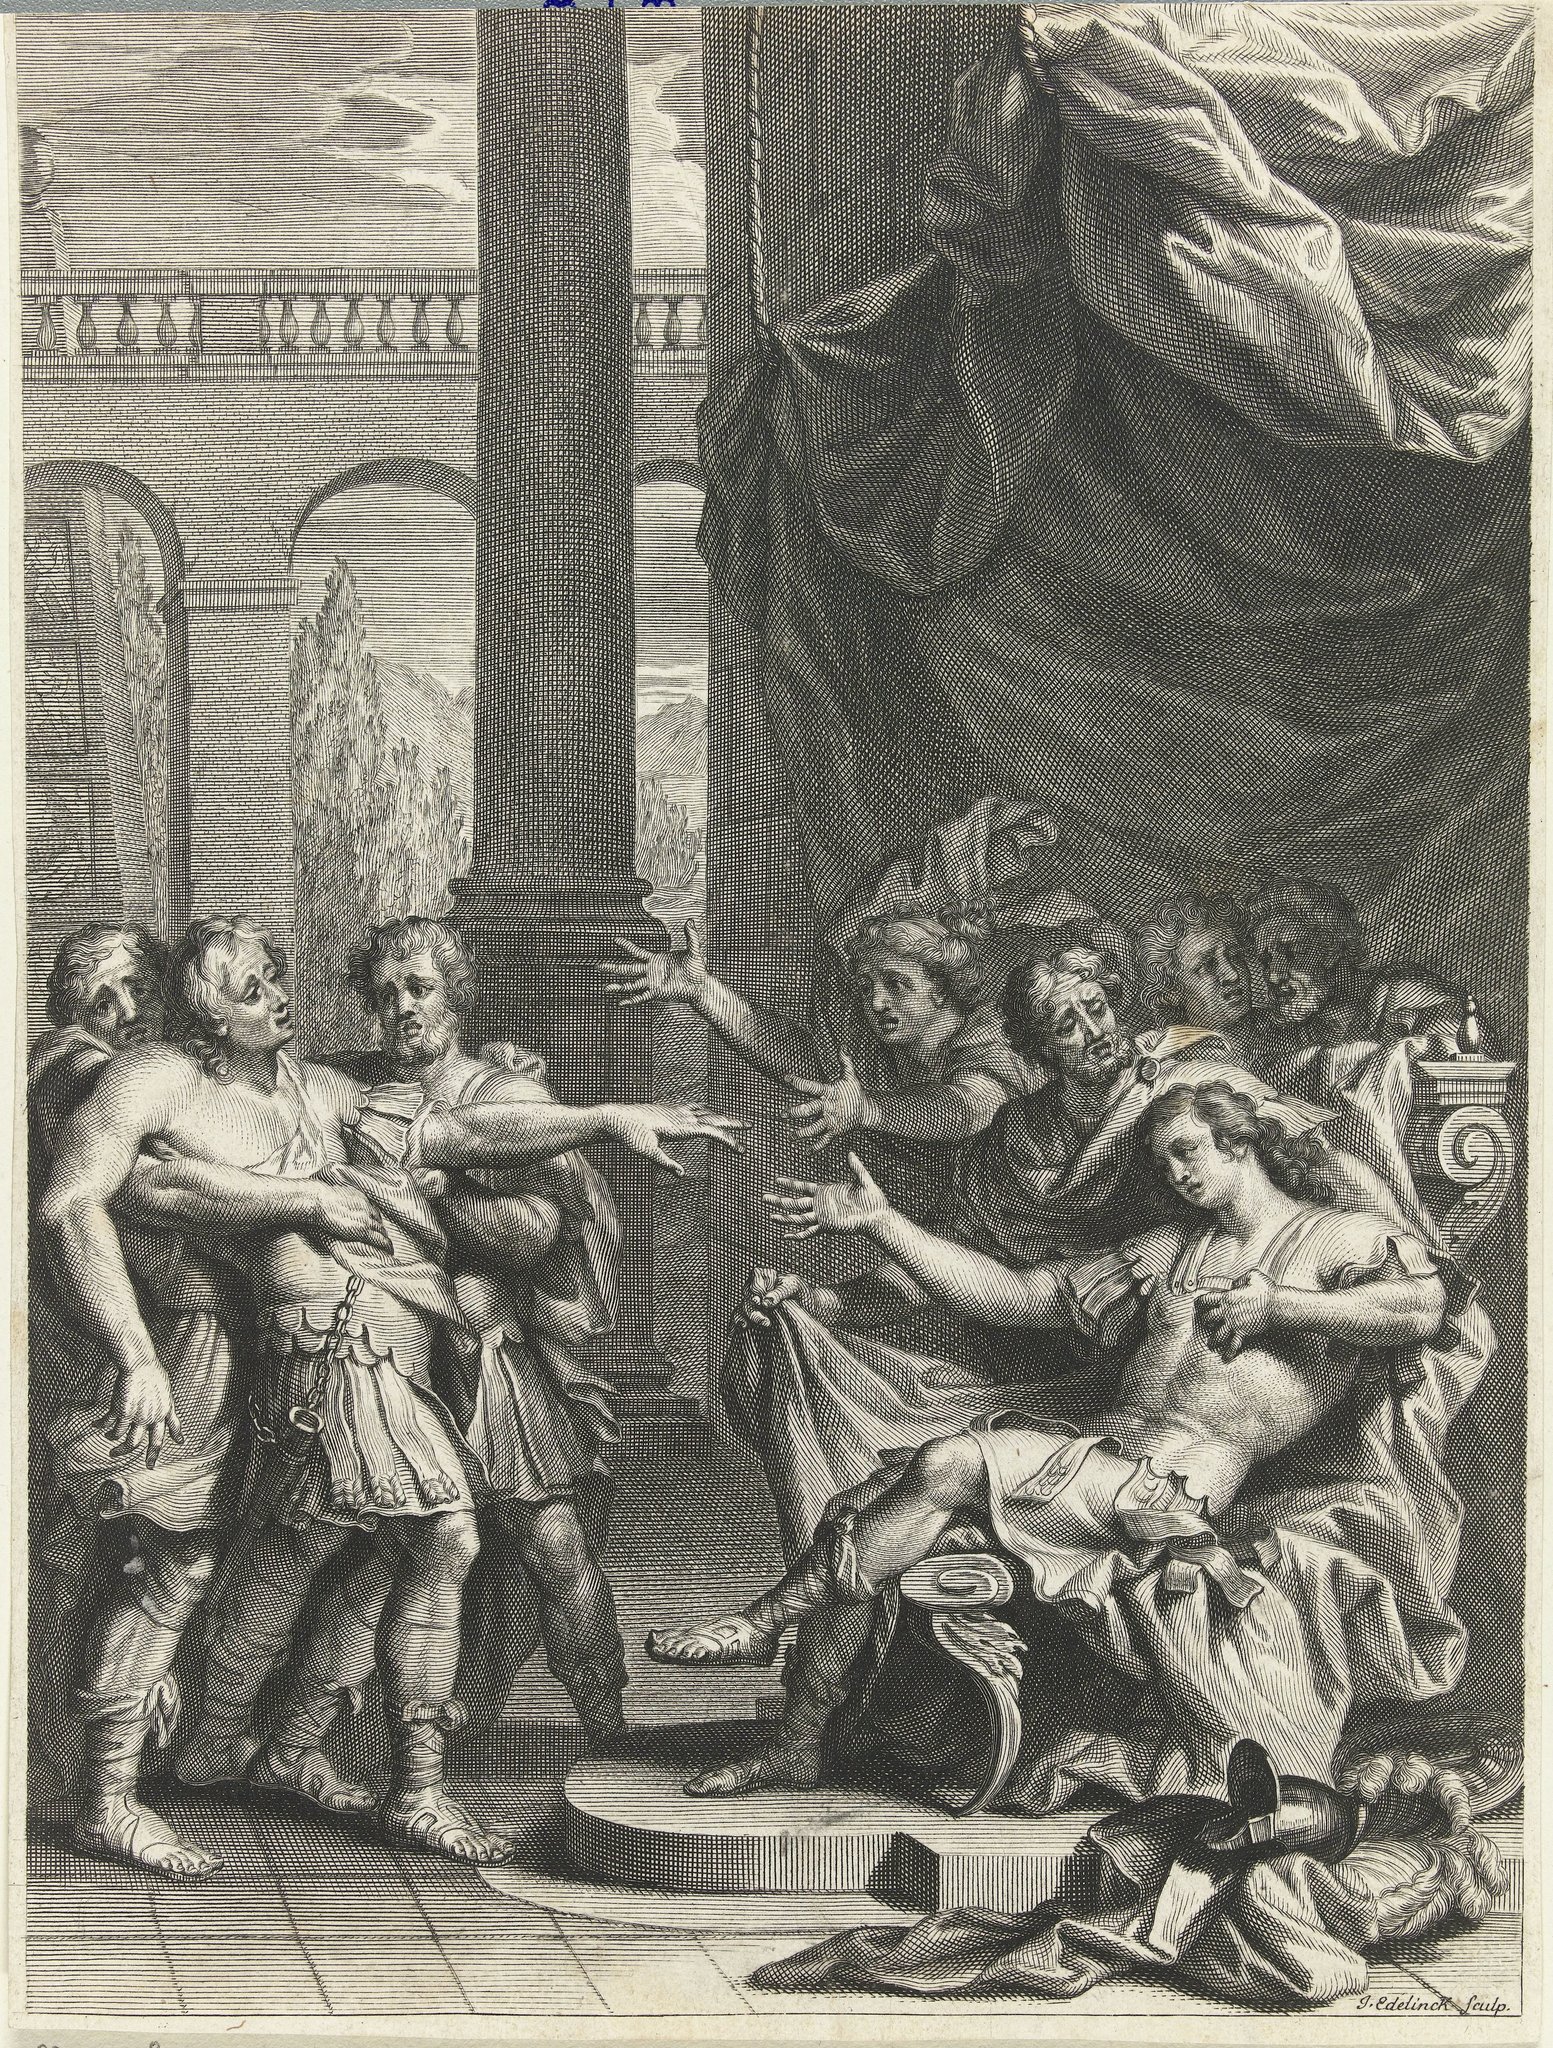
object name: titelblad, titelpagina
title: Titelpagina voor Caroli Ruaei e Societate Jesu Carminum libri quatuor, Parijs 1680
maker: jan edelinck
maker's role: print maker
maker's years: 1643-1680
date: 1680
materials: paper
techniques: engraving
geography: paris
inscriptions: collector's mark: Lugt 240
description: Een persoon in Romeinse kleding wordt vastgehouden door twee mannen, terwijl hij zijn hand uitstrekt naar een zittende man bijgestaan door vier anderen. De zittende man heeft zijn hand bij het hart en strekt de andere uit. Op de voorgrond naast hem liggen een mantel en een helm.